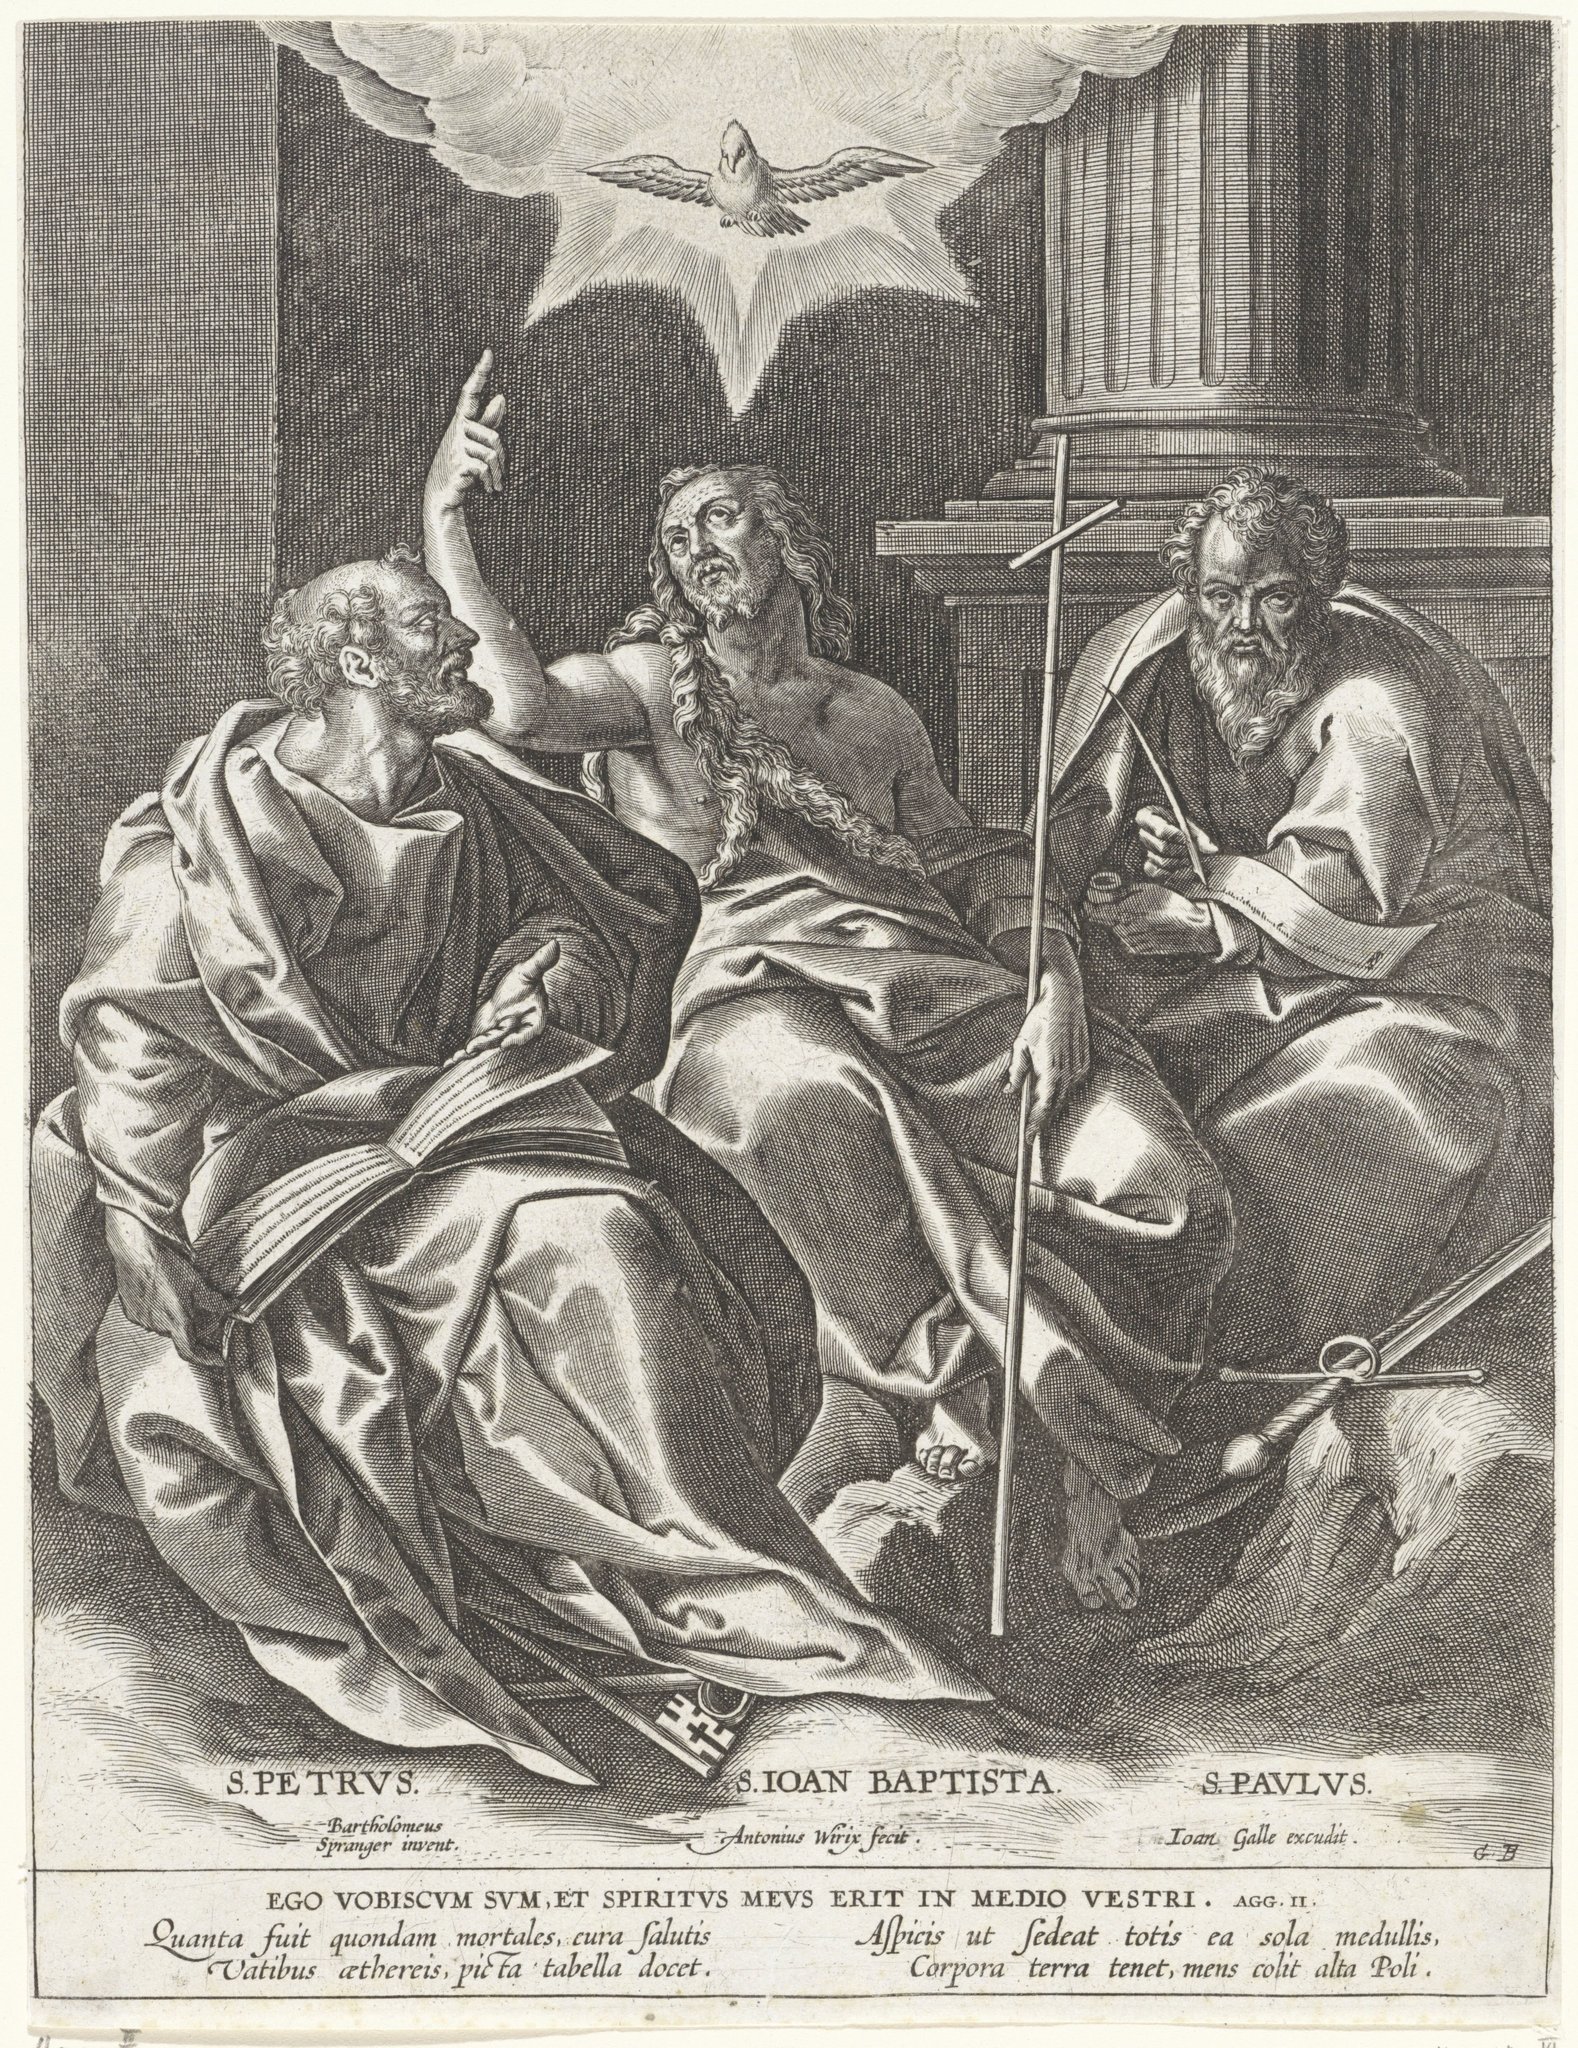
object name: print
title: Johannes de Doper met Petrus en Paulus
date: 1610-1676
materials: paper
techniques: engraving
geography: antwerp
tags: john the baptist; possible attributes: book, reed cross, baptismal cup, honeycomb, lamb, staff, the apostle peter, first bishop of rome; possible attributes: book, cock, (upturned) cross, (triple) crozier, fish, key, scroll, ship, tiara, the apostle paul of tarsus; possible attributes: book, scroll, sword, holy ghost represented as a dove (in flames)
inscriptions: collector's mark: Lugt 2228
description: Johannes de Doper wordt geflankeerd door de H. Petrus (sleutel ligt aan zijn voeten) en de H. Paulus (zwaard ligt aan zijn voeten). Ze zitten bij een zuil. Johannes wijst naar boven, naar de duif van de Heilige Geest. In de marge een Bijbelcitaat uit Hag. 2 en een vierregelig onderschrift, in twee kolommen, in het Latijn. Rechtsonder gemerkt met een monogram G.B.